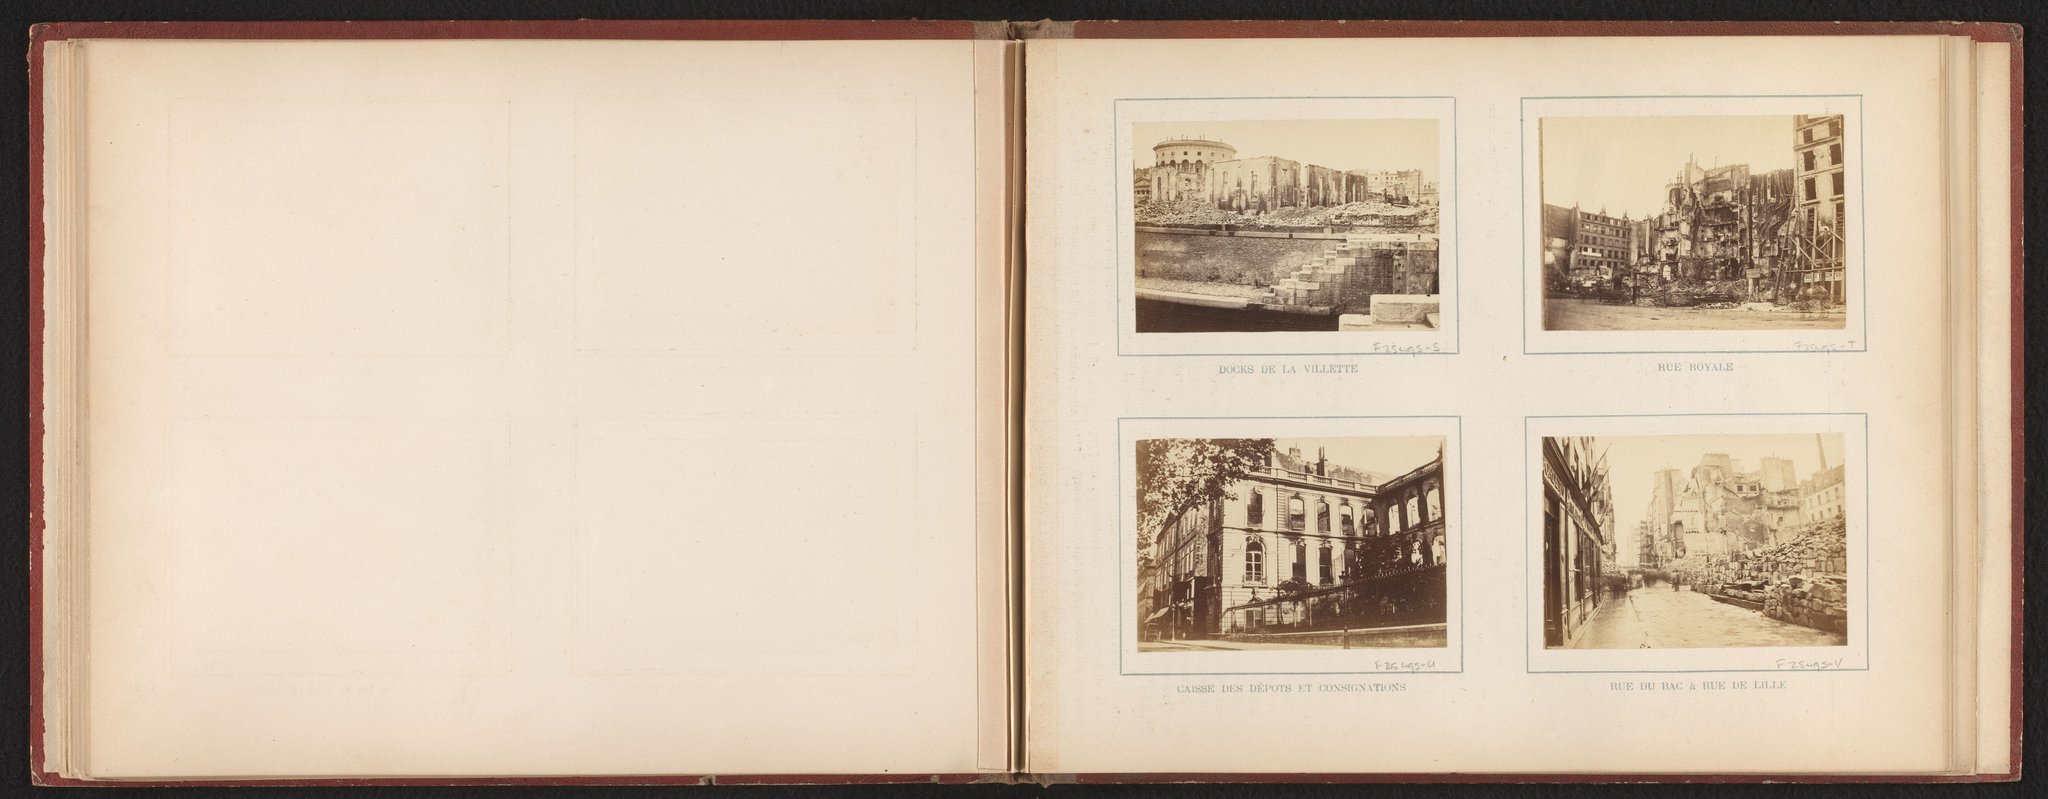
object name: page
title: Gezicht op het verwoeste Caisse des dépôts et consignations in Parijs na de semaine sanglante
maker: Anonymous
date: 1871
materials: paper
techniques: albumen print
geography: paris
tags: ruin of a building ~ architecture